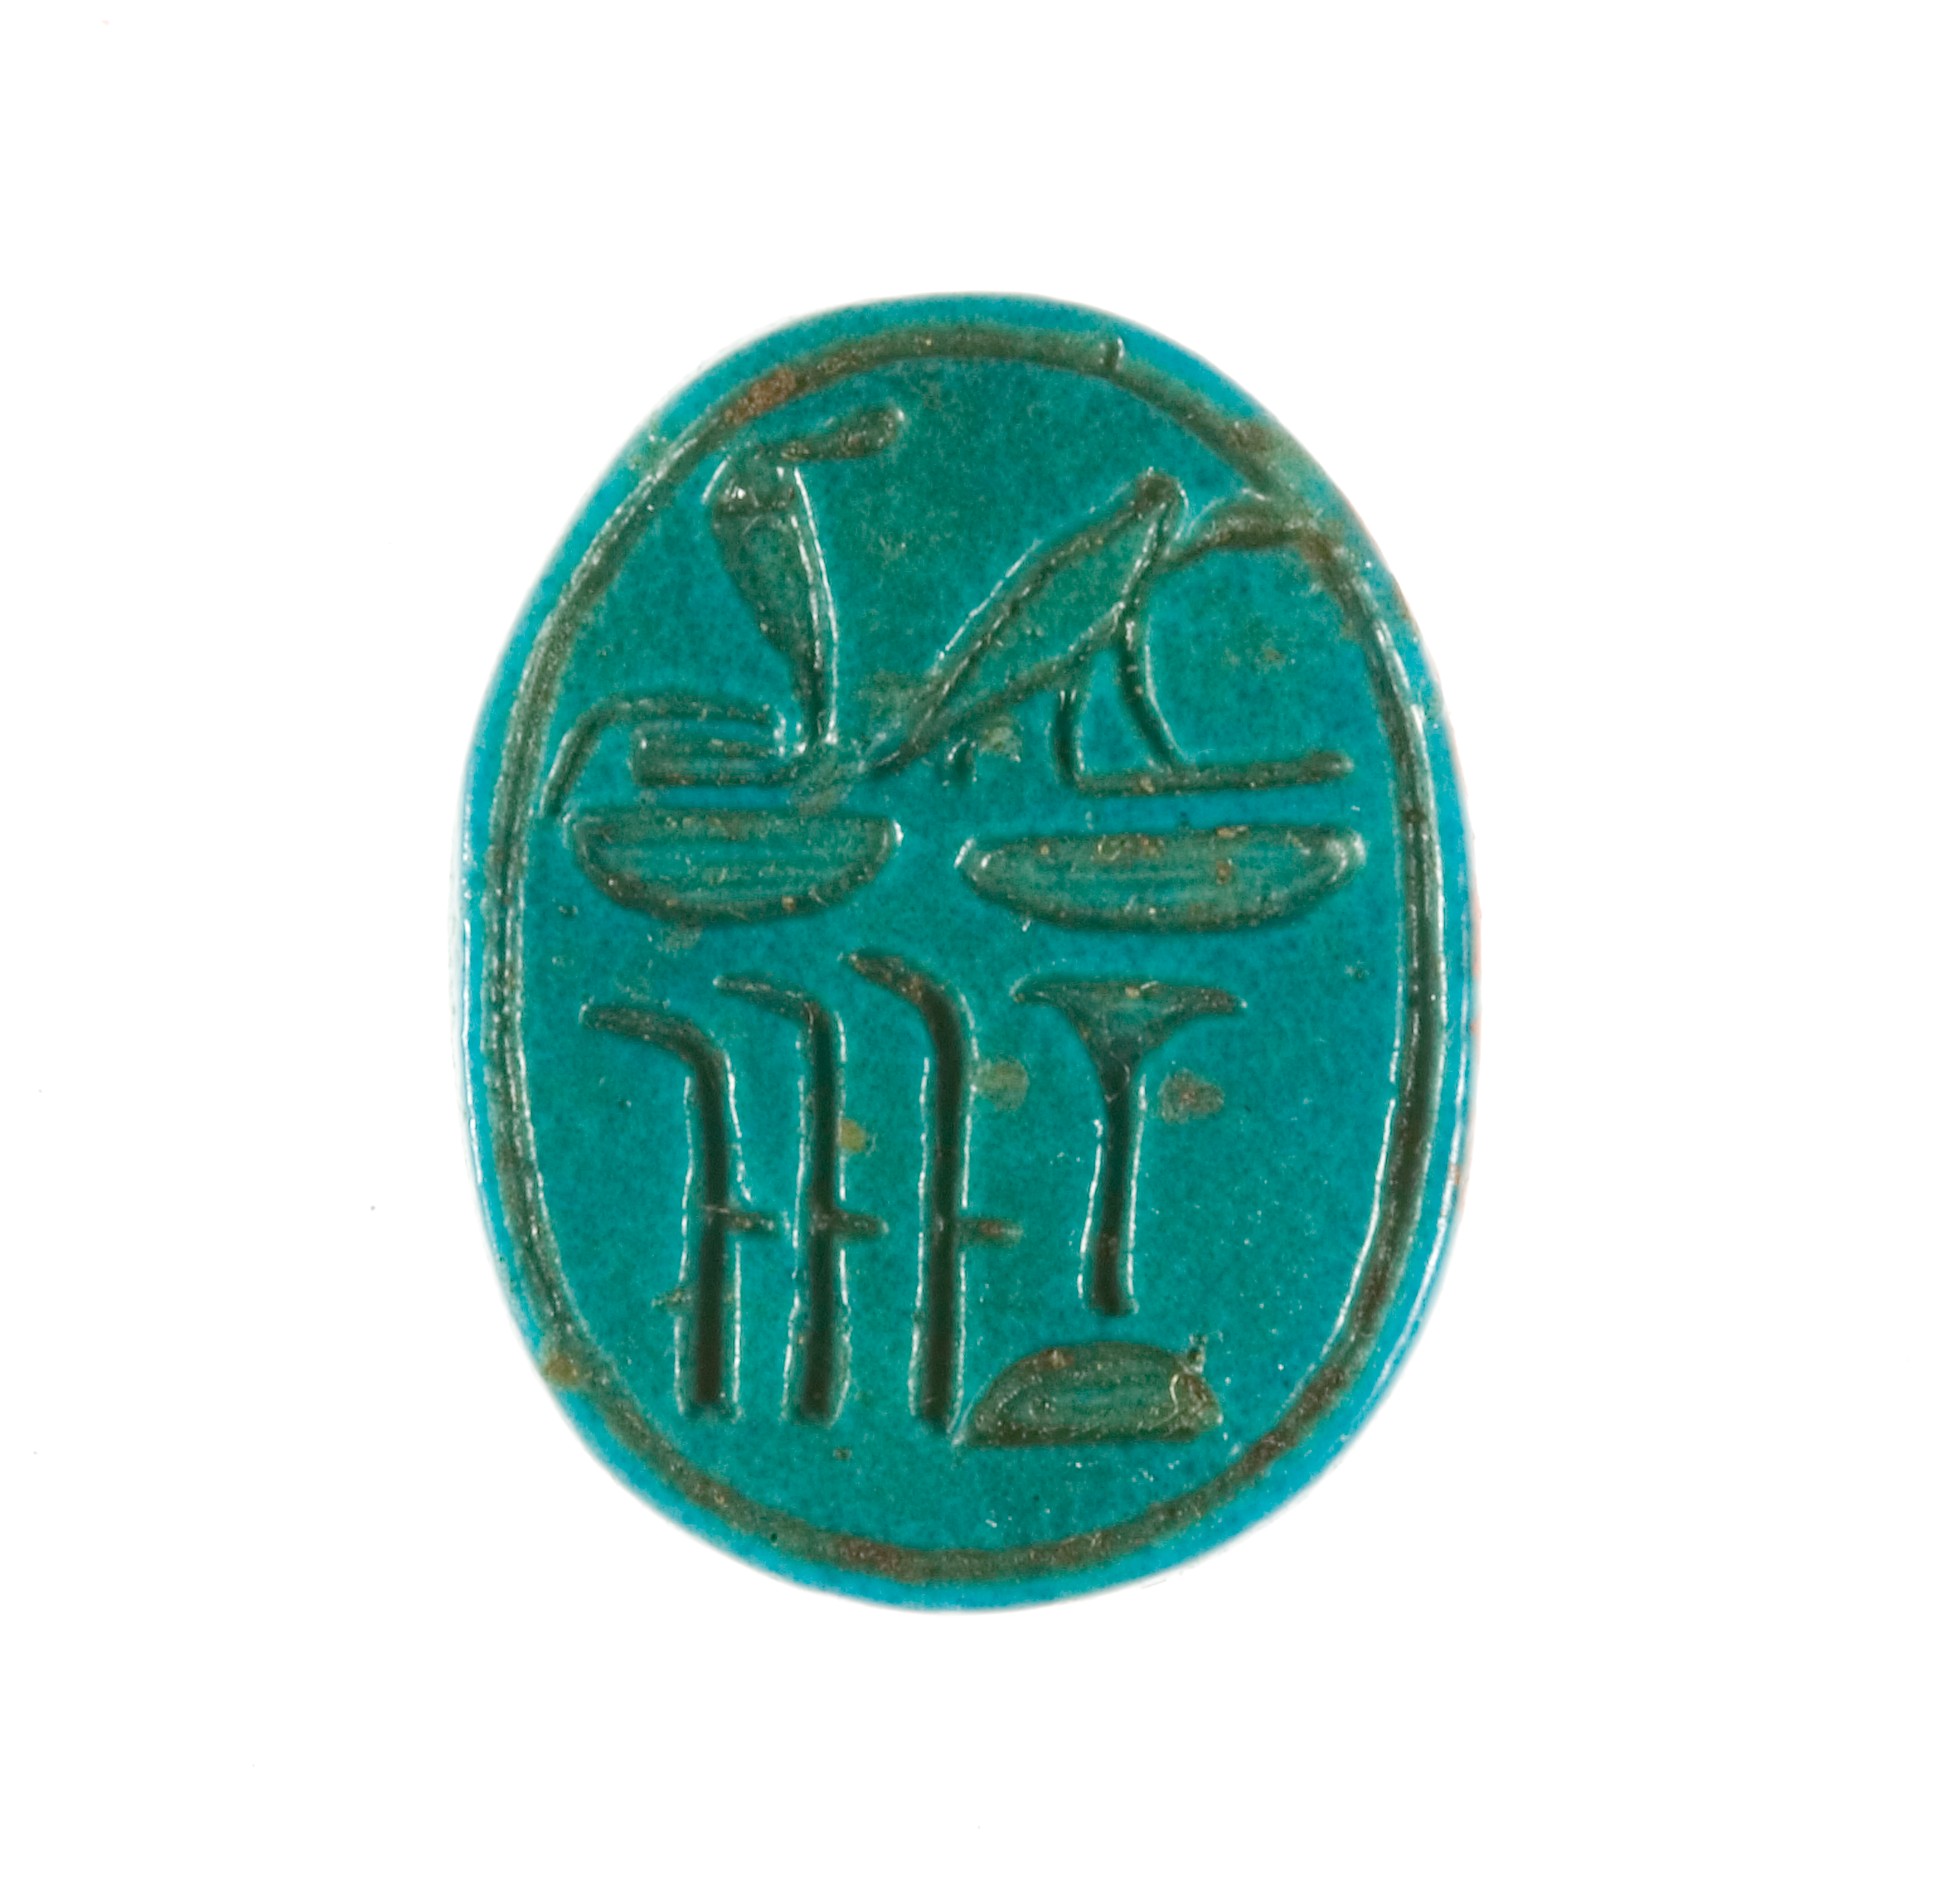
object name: scarab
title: Scarab "Two Ladies, Wadjetrenput"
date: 1479-1458 BCE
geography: egypt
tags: hieroglyphs,scarabs